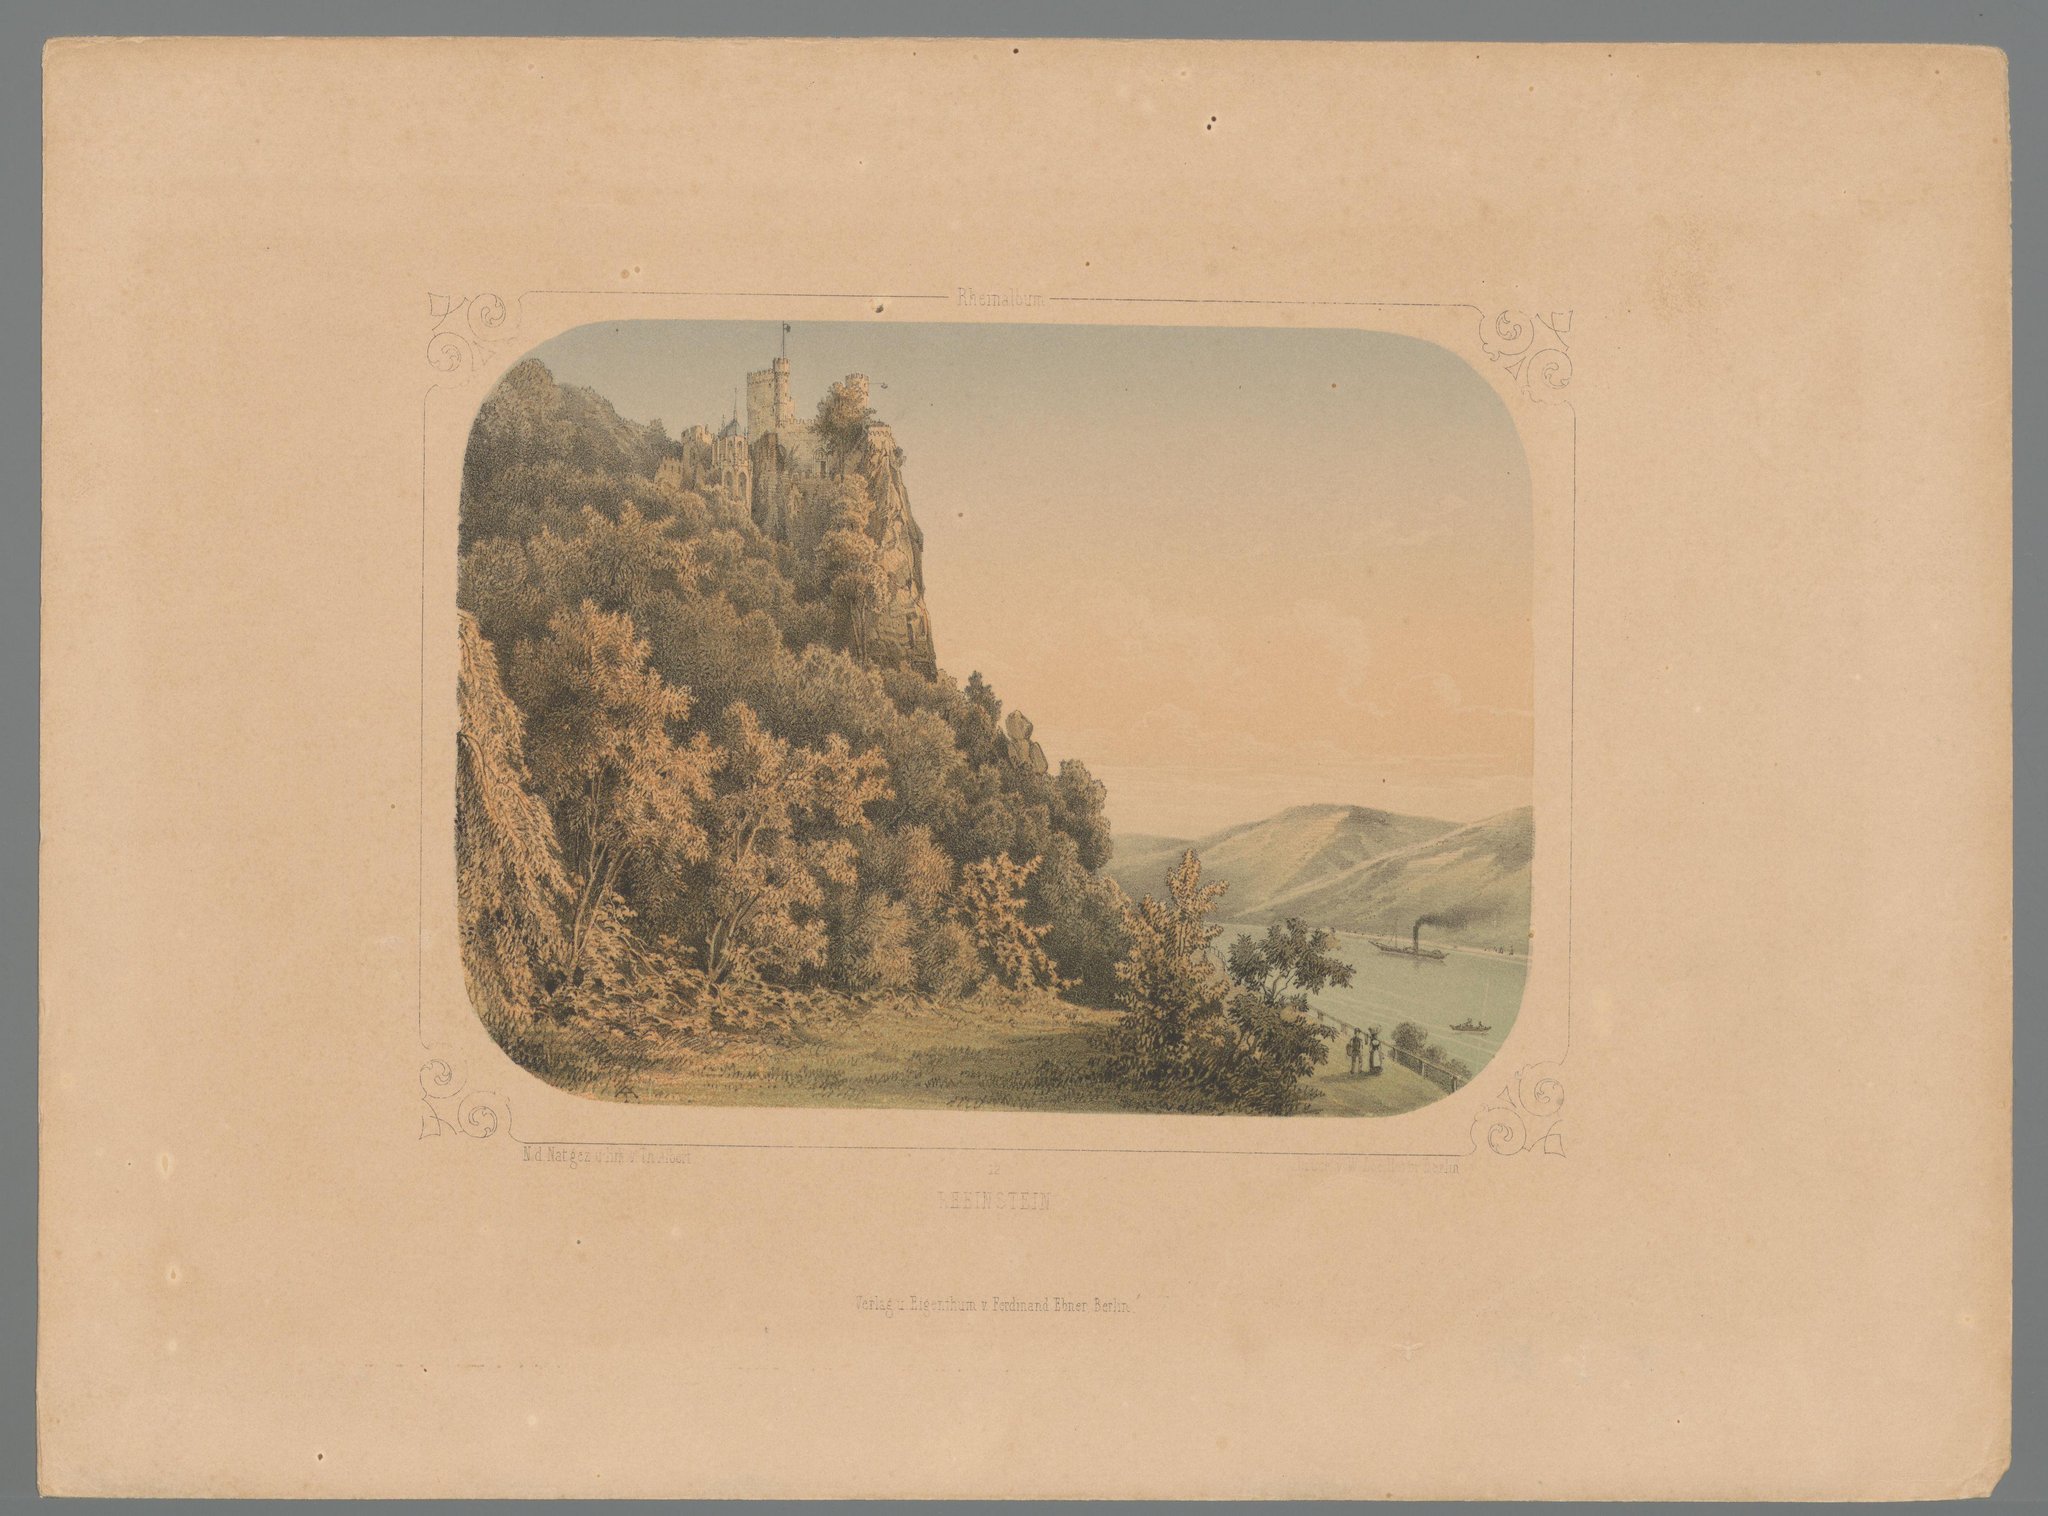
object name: print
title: Gezicht op Burcht Rheinstein aan de Rijn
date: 1858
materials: paper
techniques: lithograph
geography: berlin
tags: river, landscape with tower or castle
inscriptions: collector's mark: Lugt 2228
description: Prent maakt deel uit van een serie van 36 prenten, waarbij het eveneens mogelijk was deze te laten samenbinden tot een album.